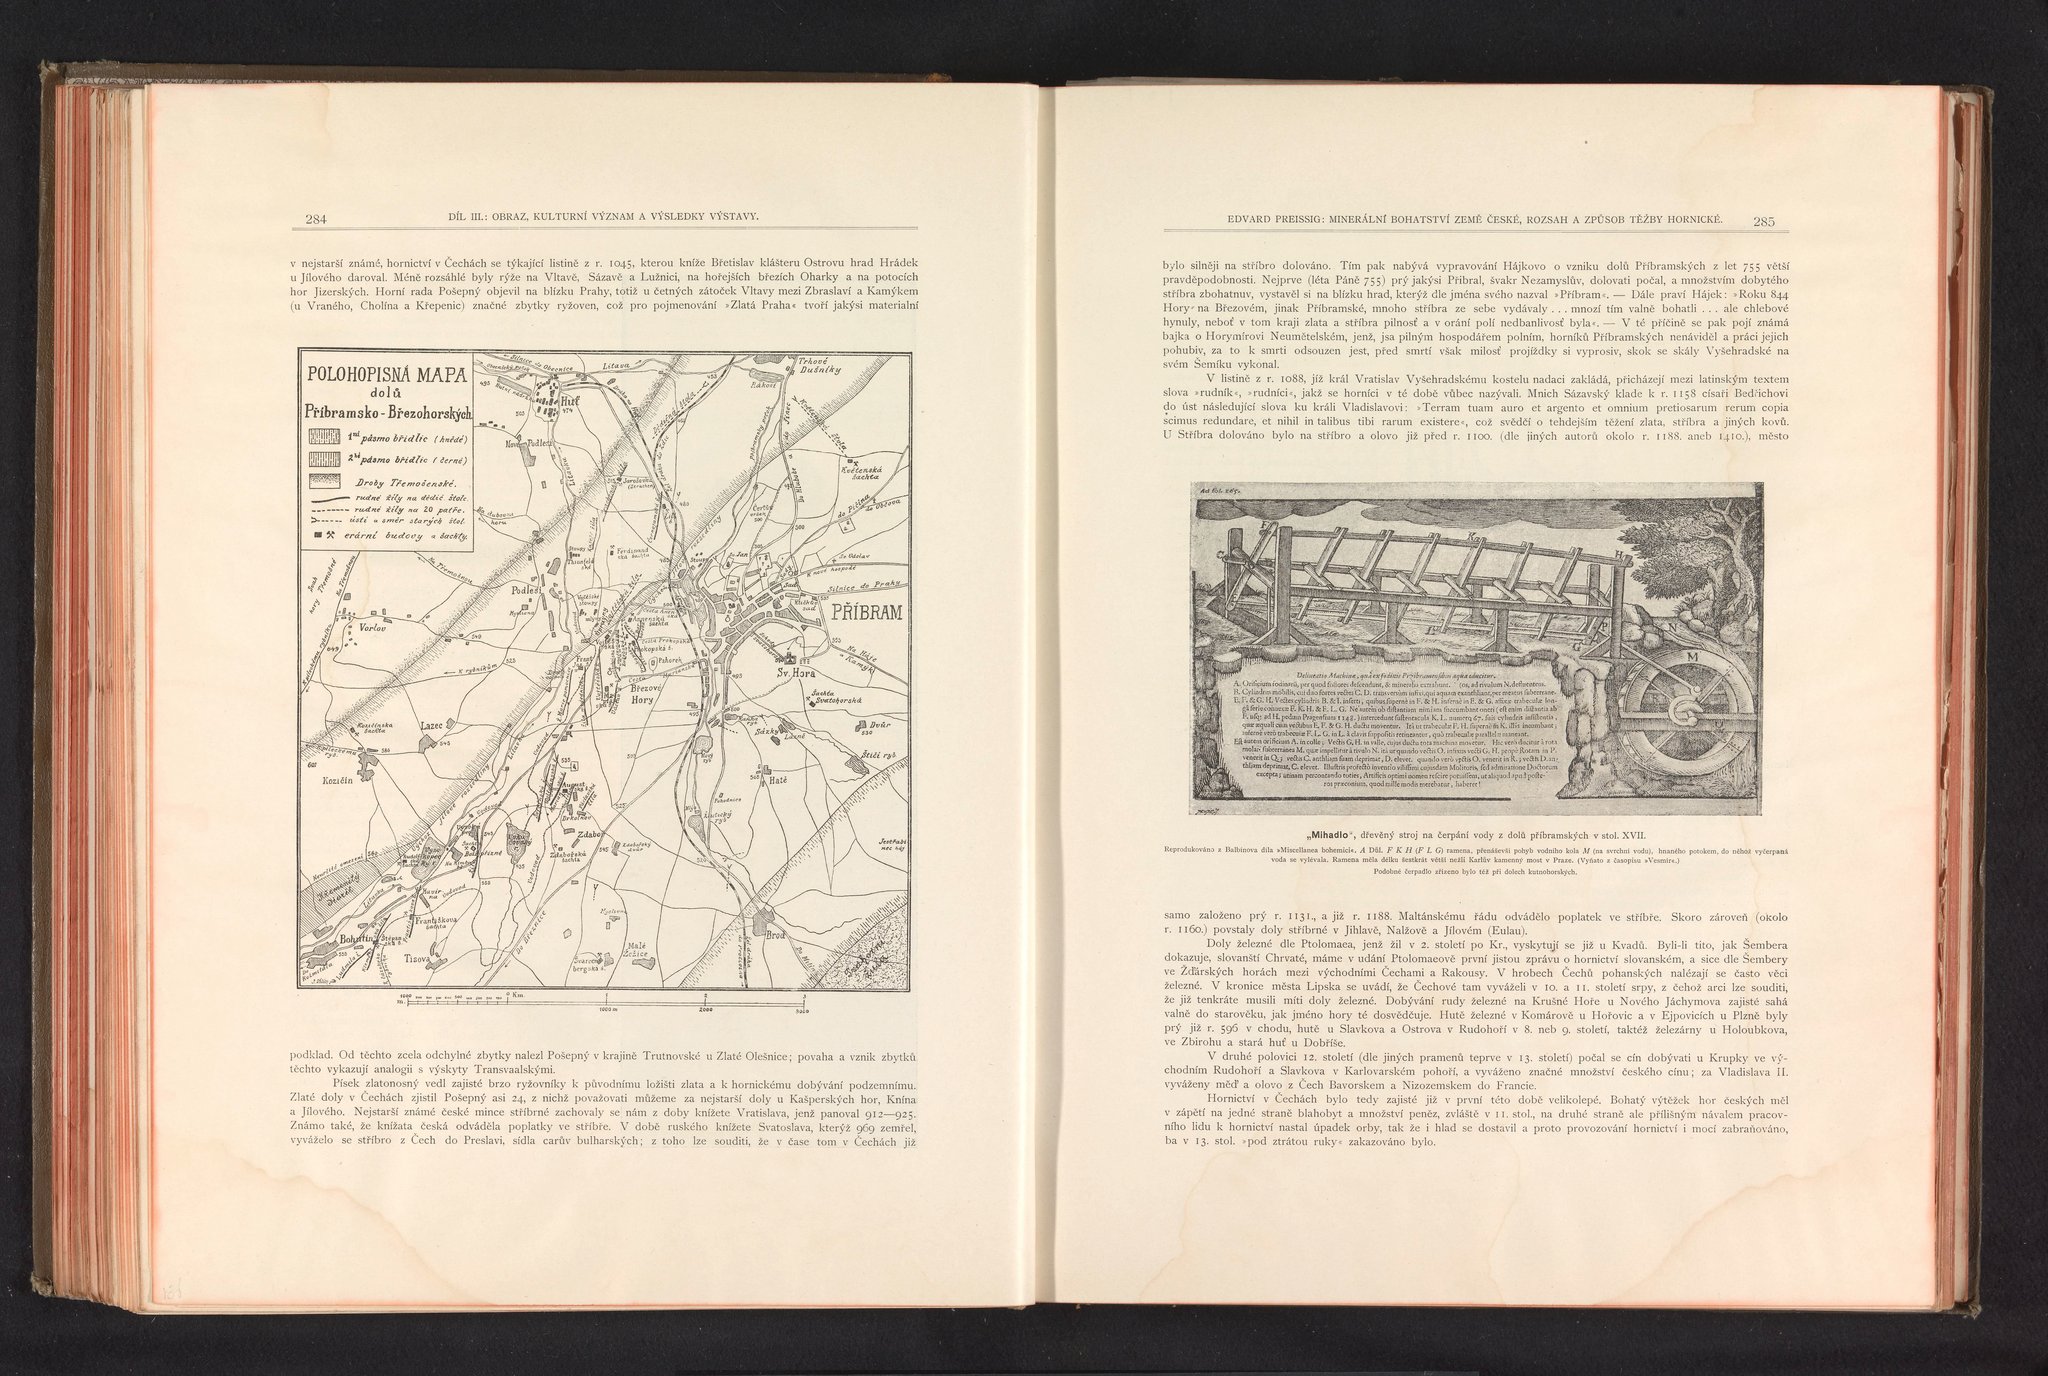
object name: photomechanical print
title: ,,Mihadlo"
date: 1892-1895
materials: paper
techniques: autotype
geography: prague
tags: printed matter